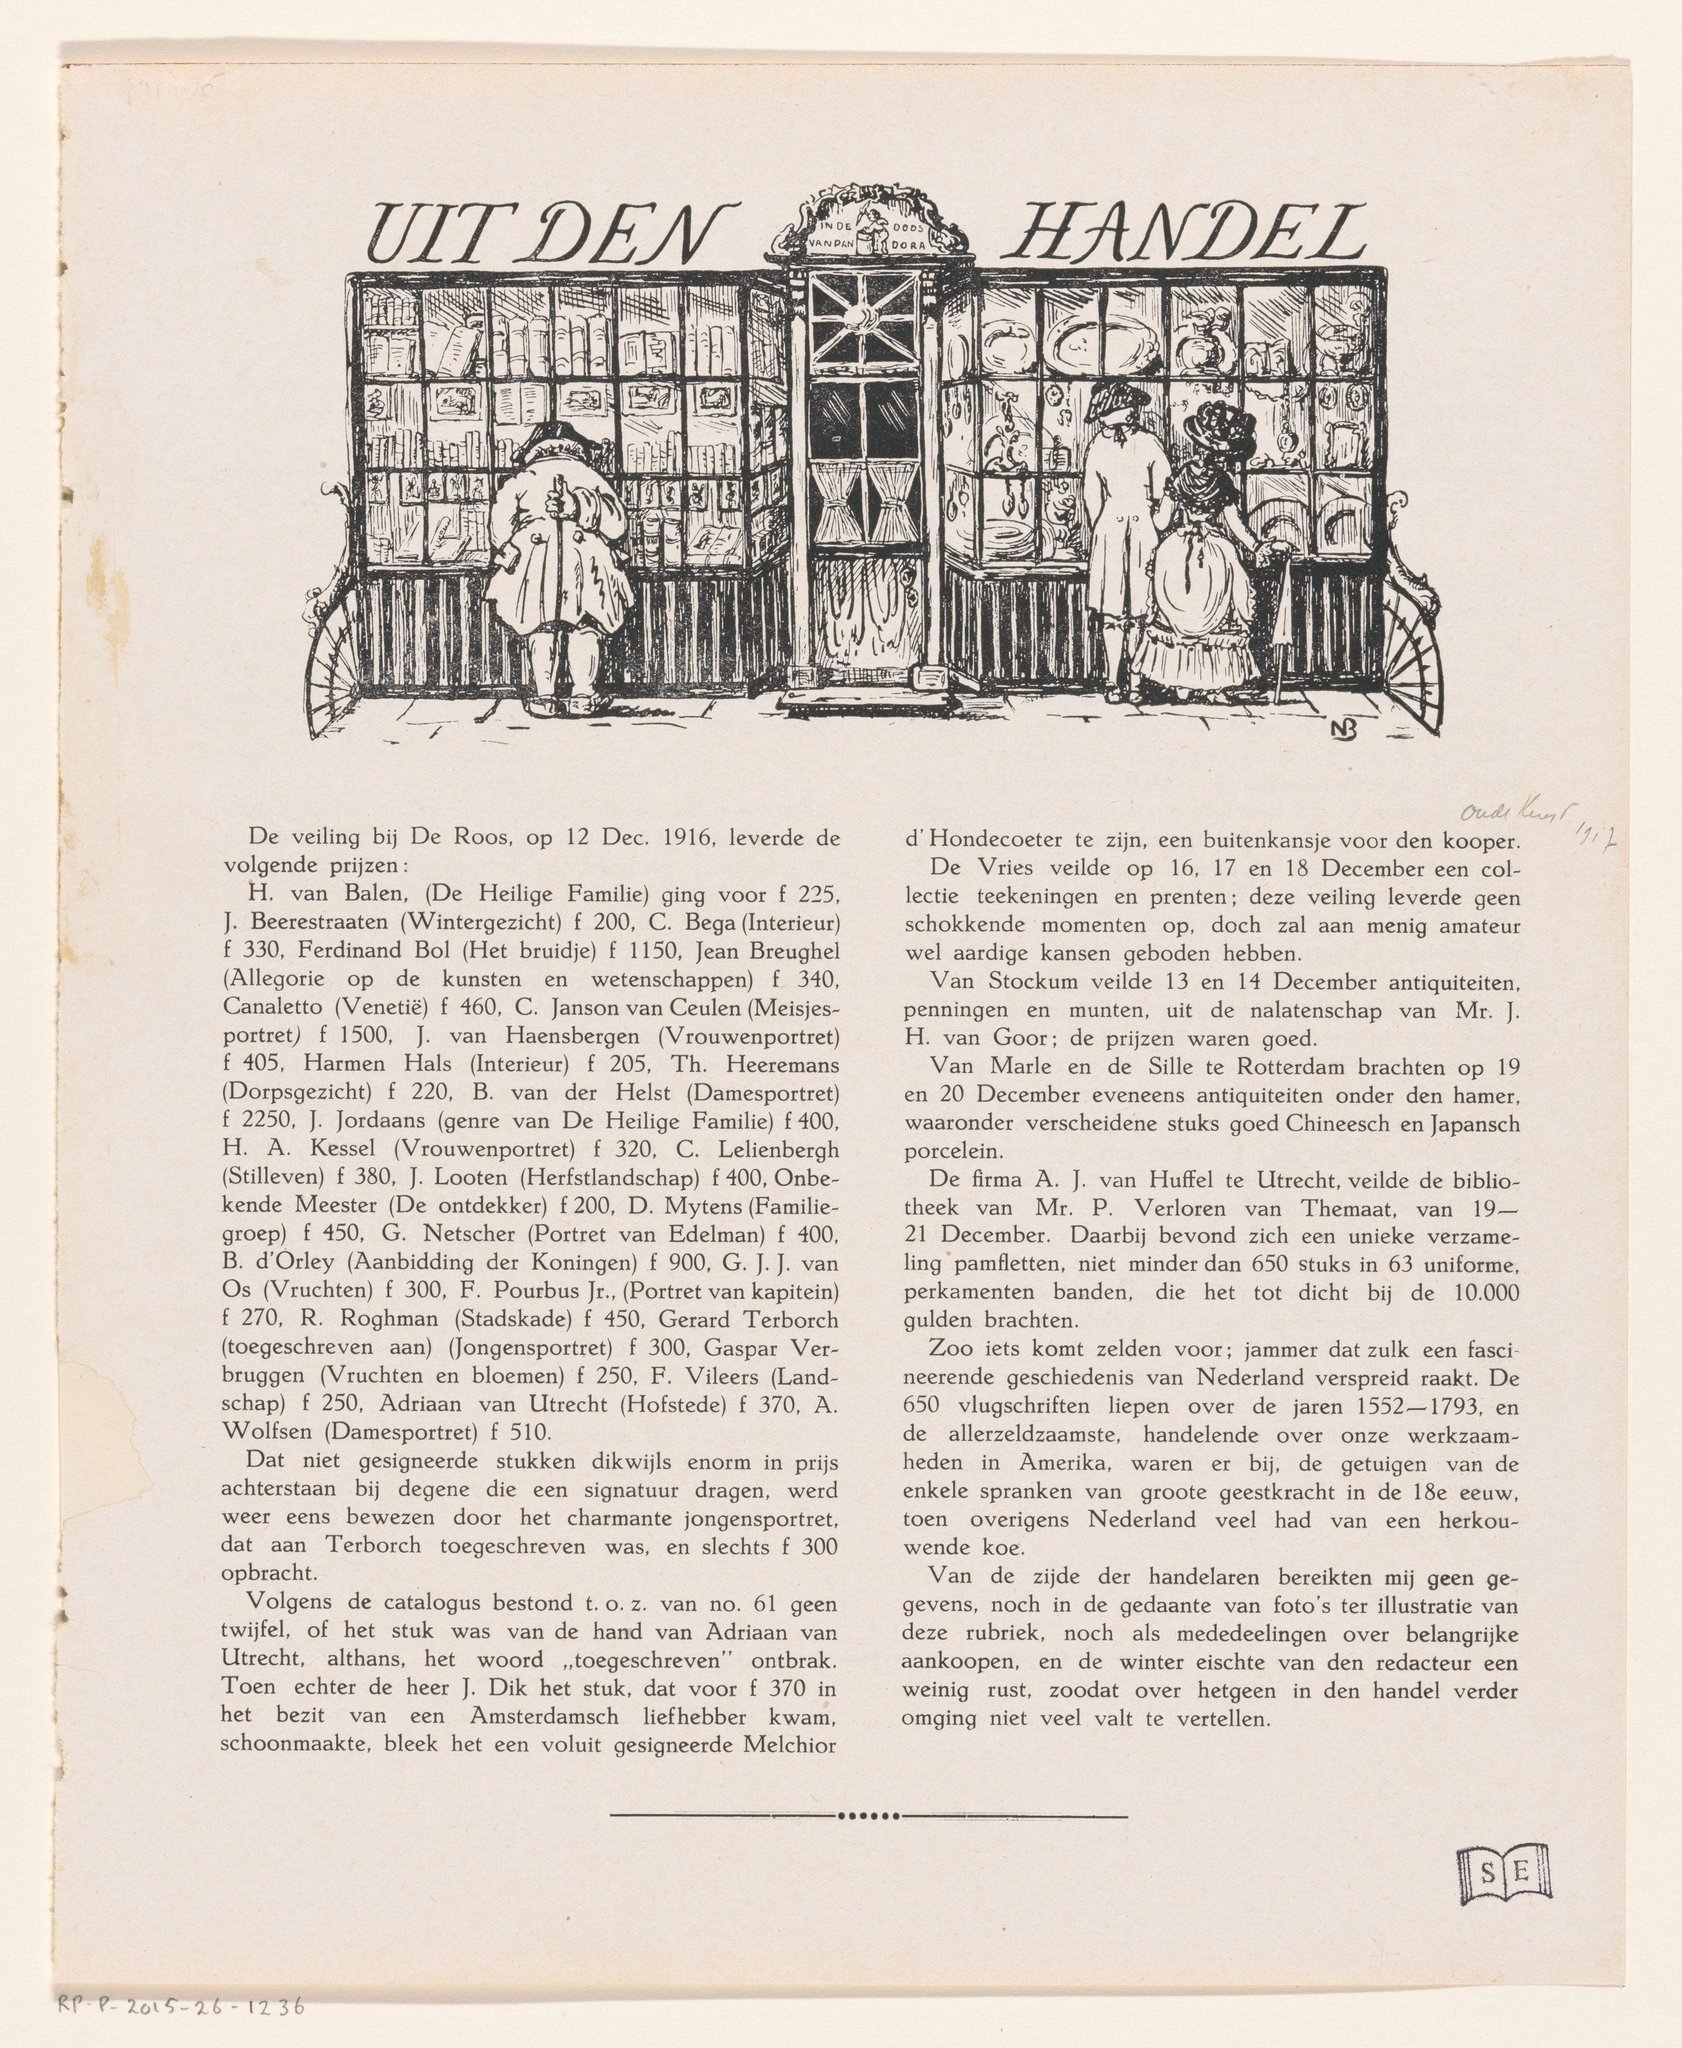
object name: print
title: Personen voor de etalage van een kunst- en boekhandel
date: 1917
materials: paper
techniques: printing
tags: art dealer, shop-window, show-window, book-shop, bookseller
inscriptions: collector's mark: Lugt 2228, collector's mark: Lugt 4779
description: Gezicht op twee etalages; de linker met boeken en de rechter met kunstvoorwerpen. Boven de deur in het midden staat de (fictieve) naam van de kunsthandel: 'In de doos van Pandora'. Voor de etalages staan twee mannen en een vrouw in negentiende-eeuwse kleding. Tekst op verso.